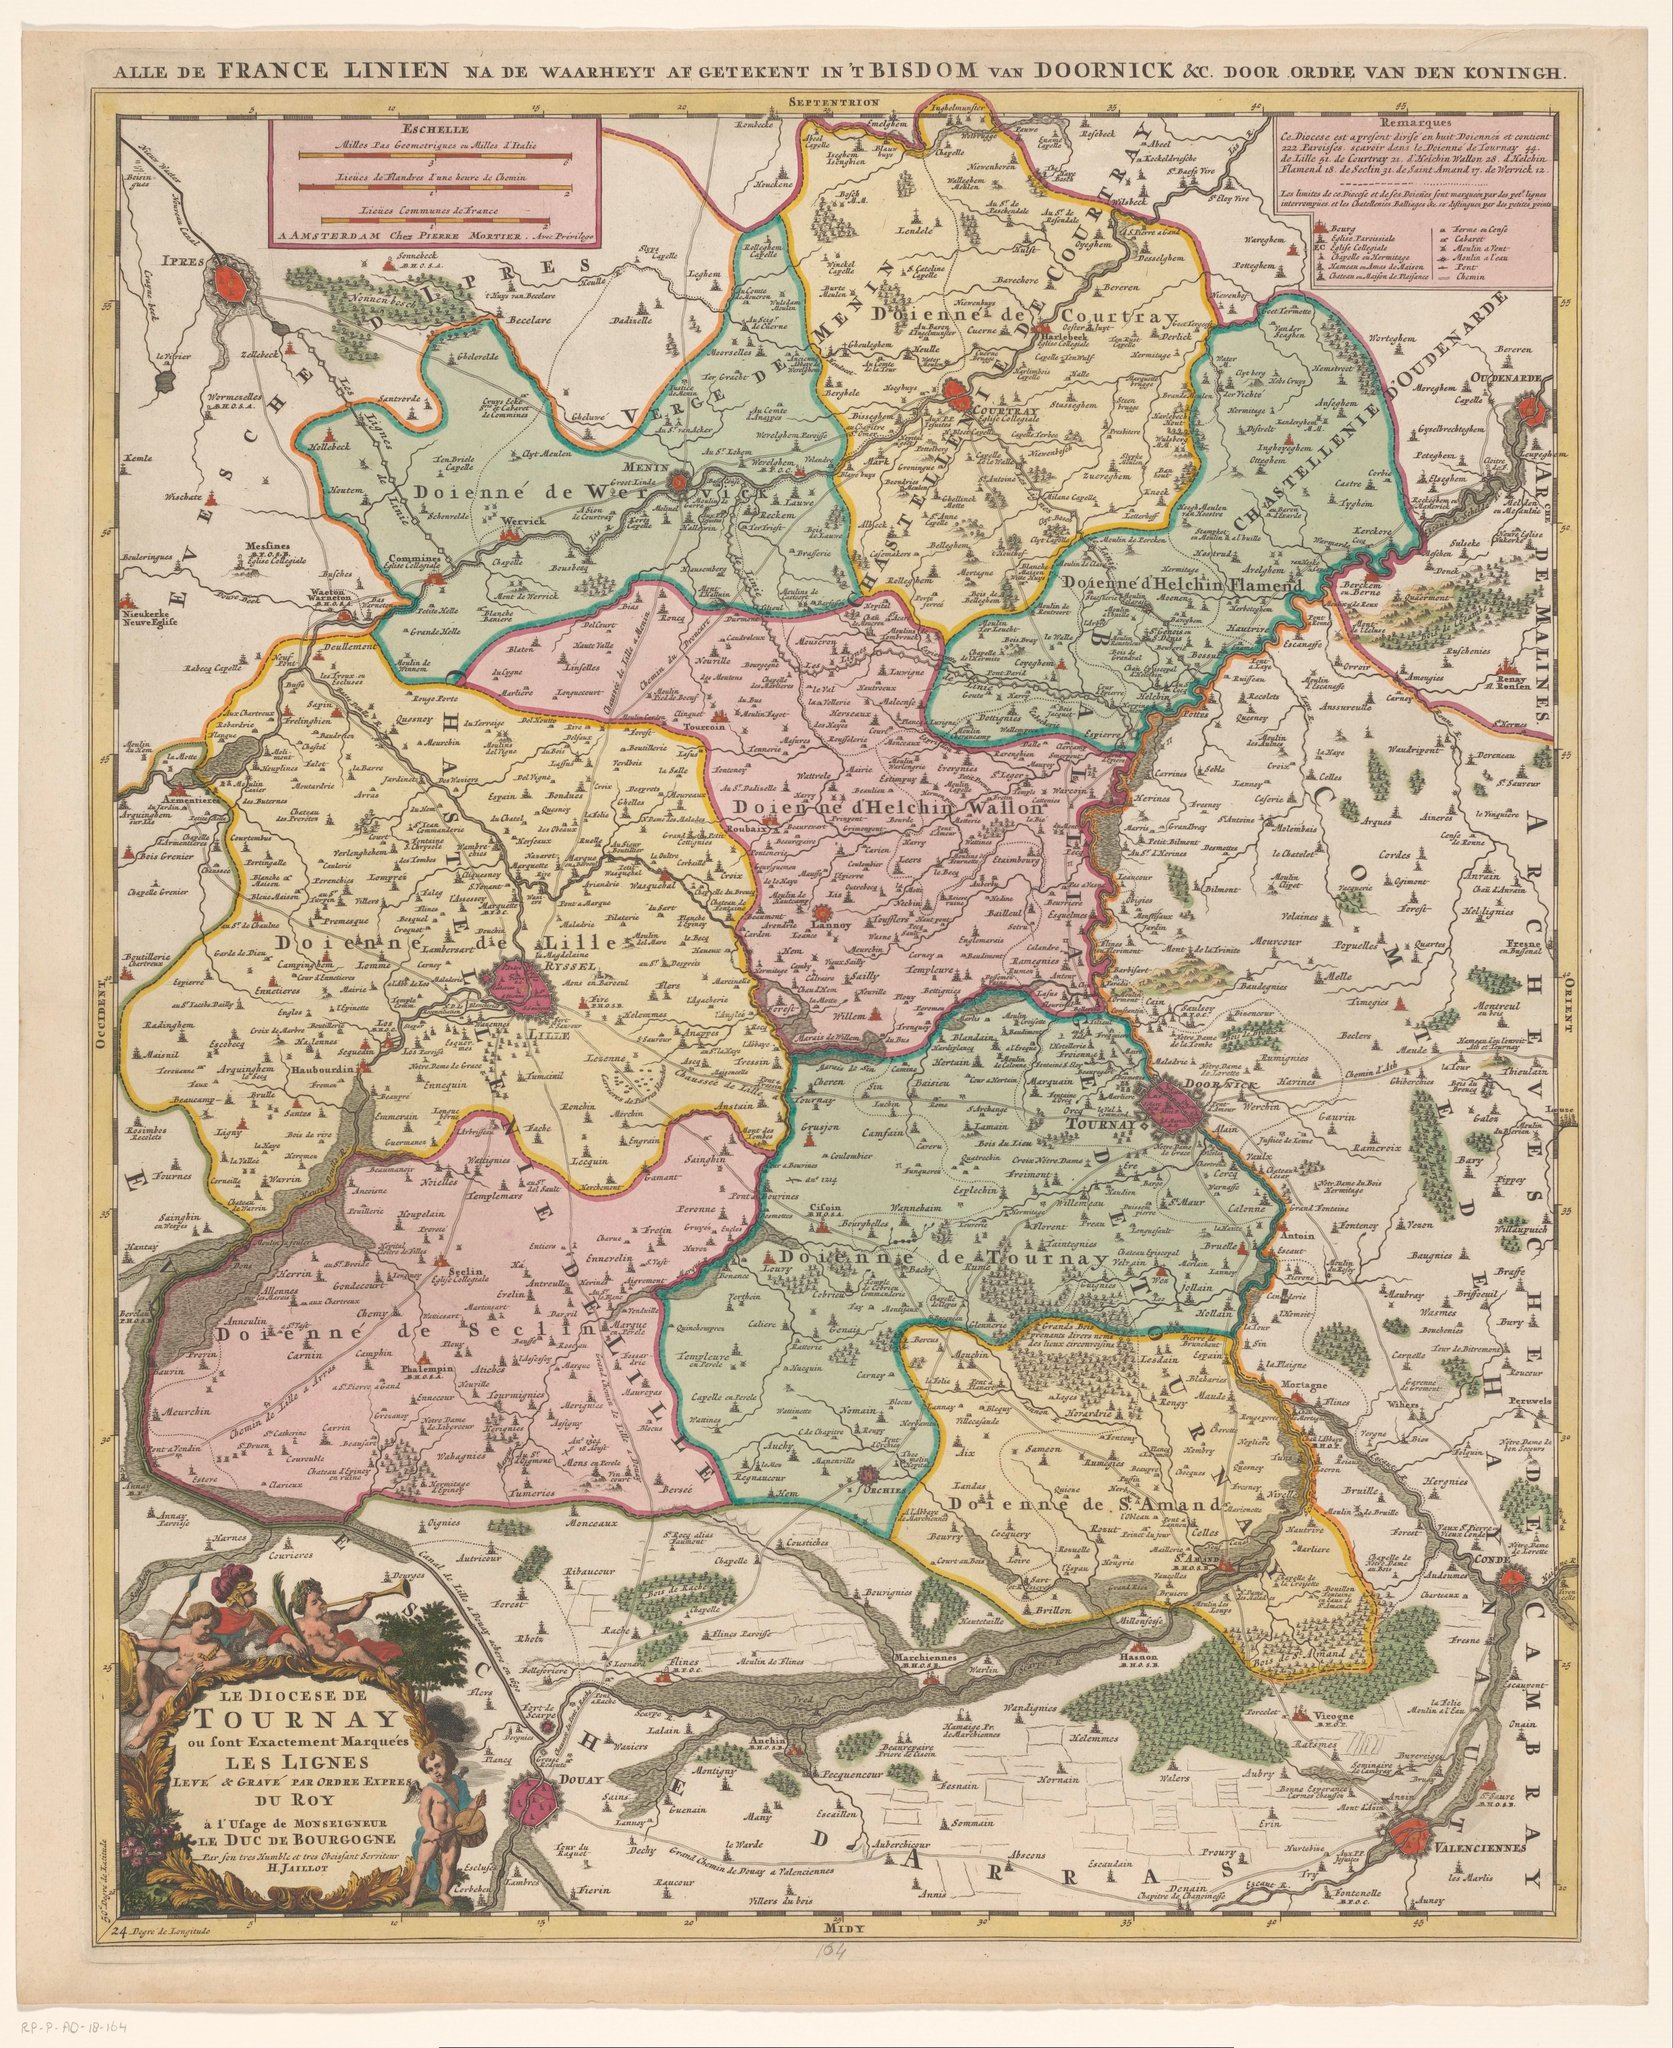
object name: print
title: Kaart van het bisdom Doornik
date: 1697-1721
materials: paper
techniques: engraving, etching, hand coloring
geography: amsterdam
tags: maps of separate countries or regions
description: Kaart van het bisdom Doornik. Linksonder een Franse titelcartouche, in een balk boven de kaart de Nederlandse titel. Rechtsboven een kader met legenda. Linksboven een kader met drie schaalstokken: 6 Milles Pas Geometriques ou Milles d'Italie / 2 Lieües de Flandres d'une heure de Chemin / 2 Lieües Communes de France. De kaart is voorzien van een gradenverdeling langs de randen.